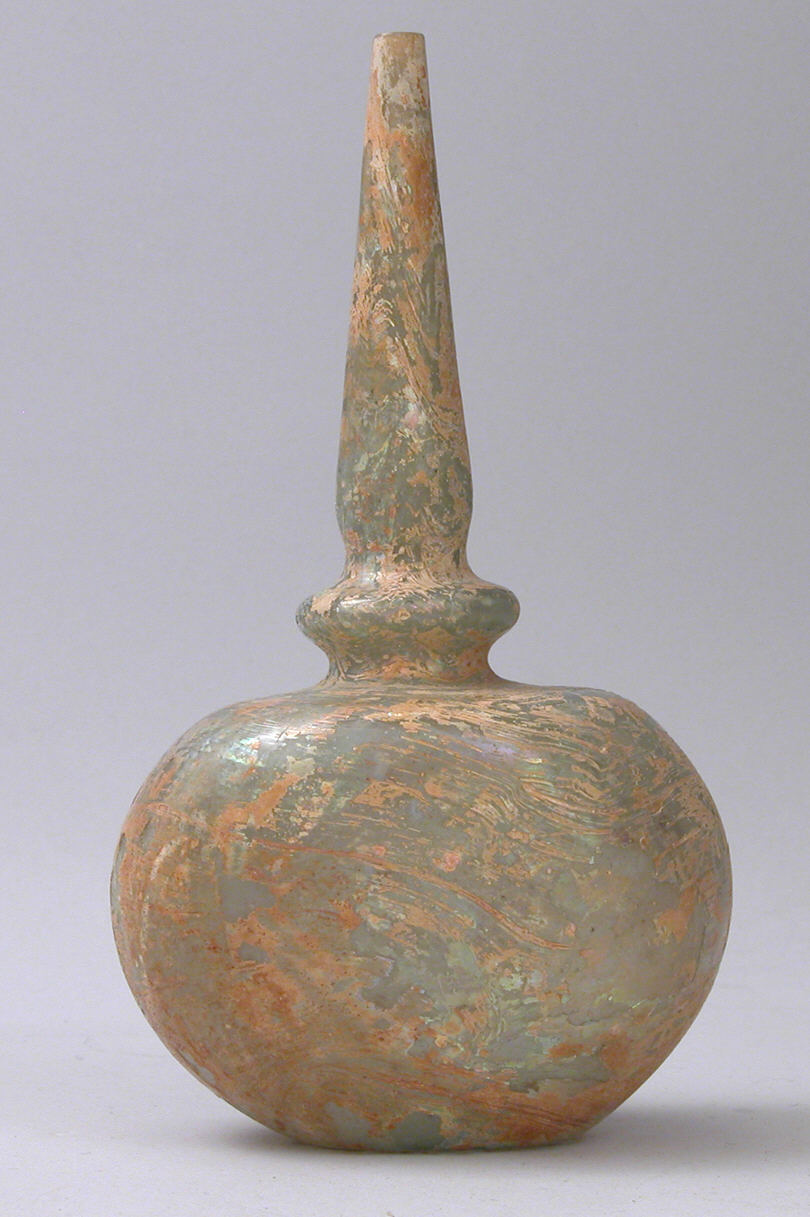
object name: bottle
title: Bottle (Qumqum)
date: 1201-1300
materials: glass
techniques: glassblowing, tooling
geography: syria